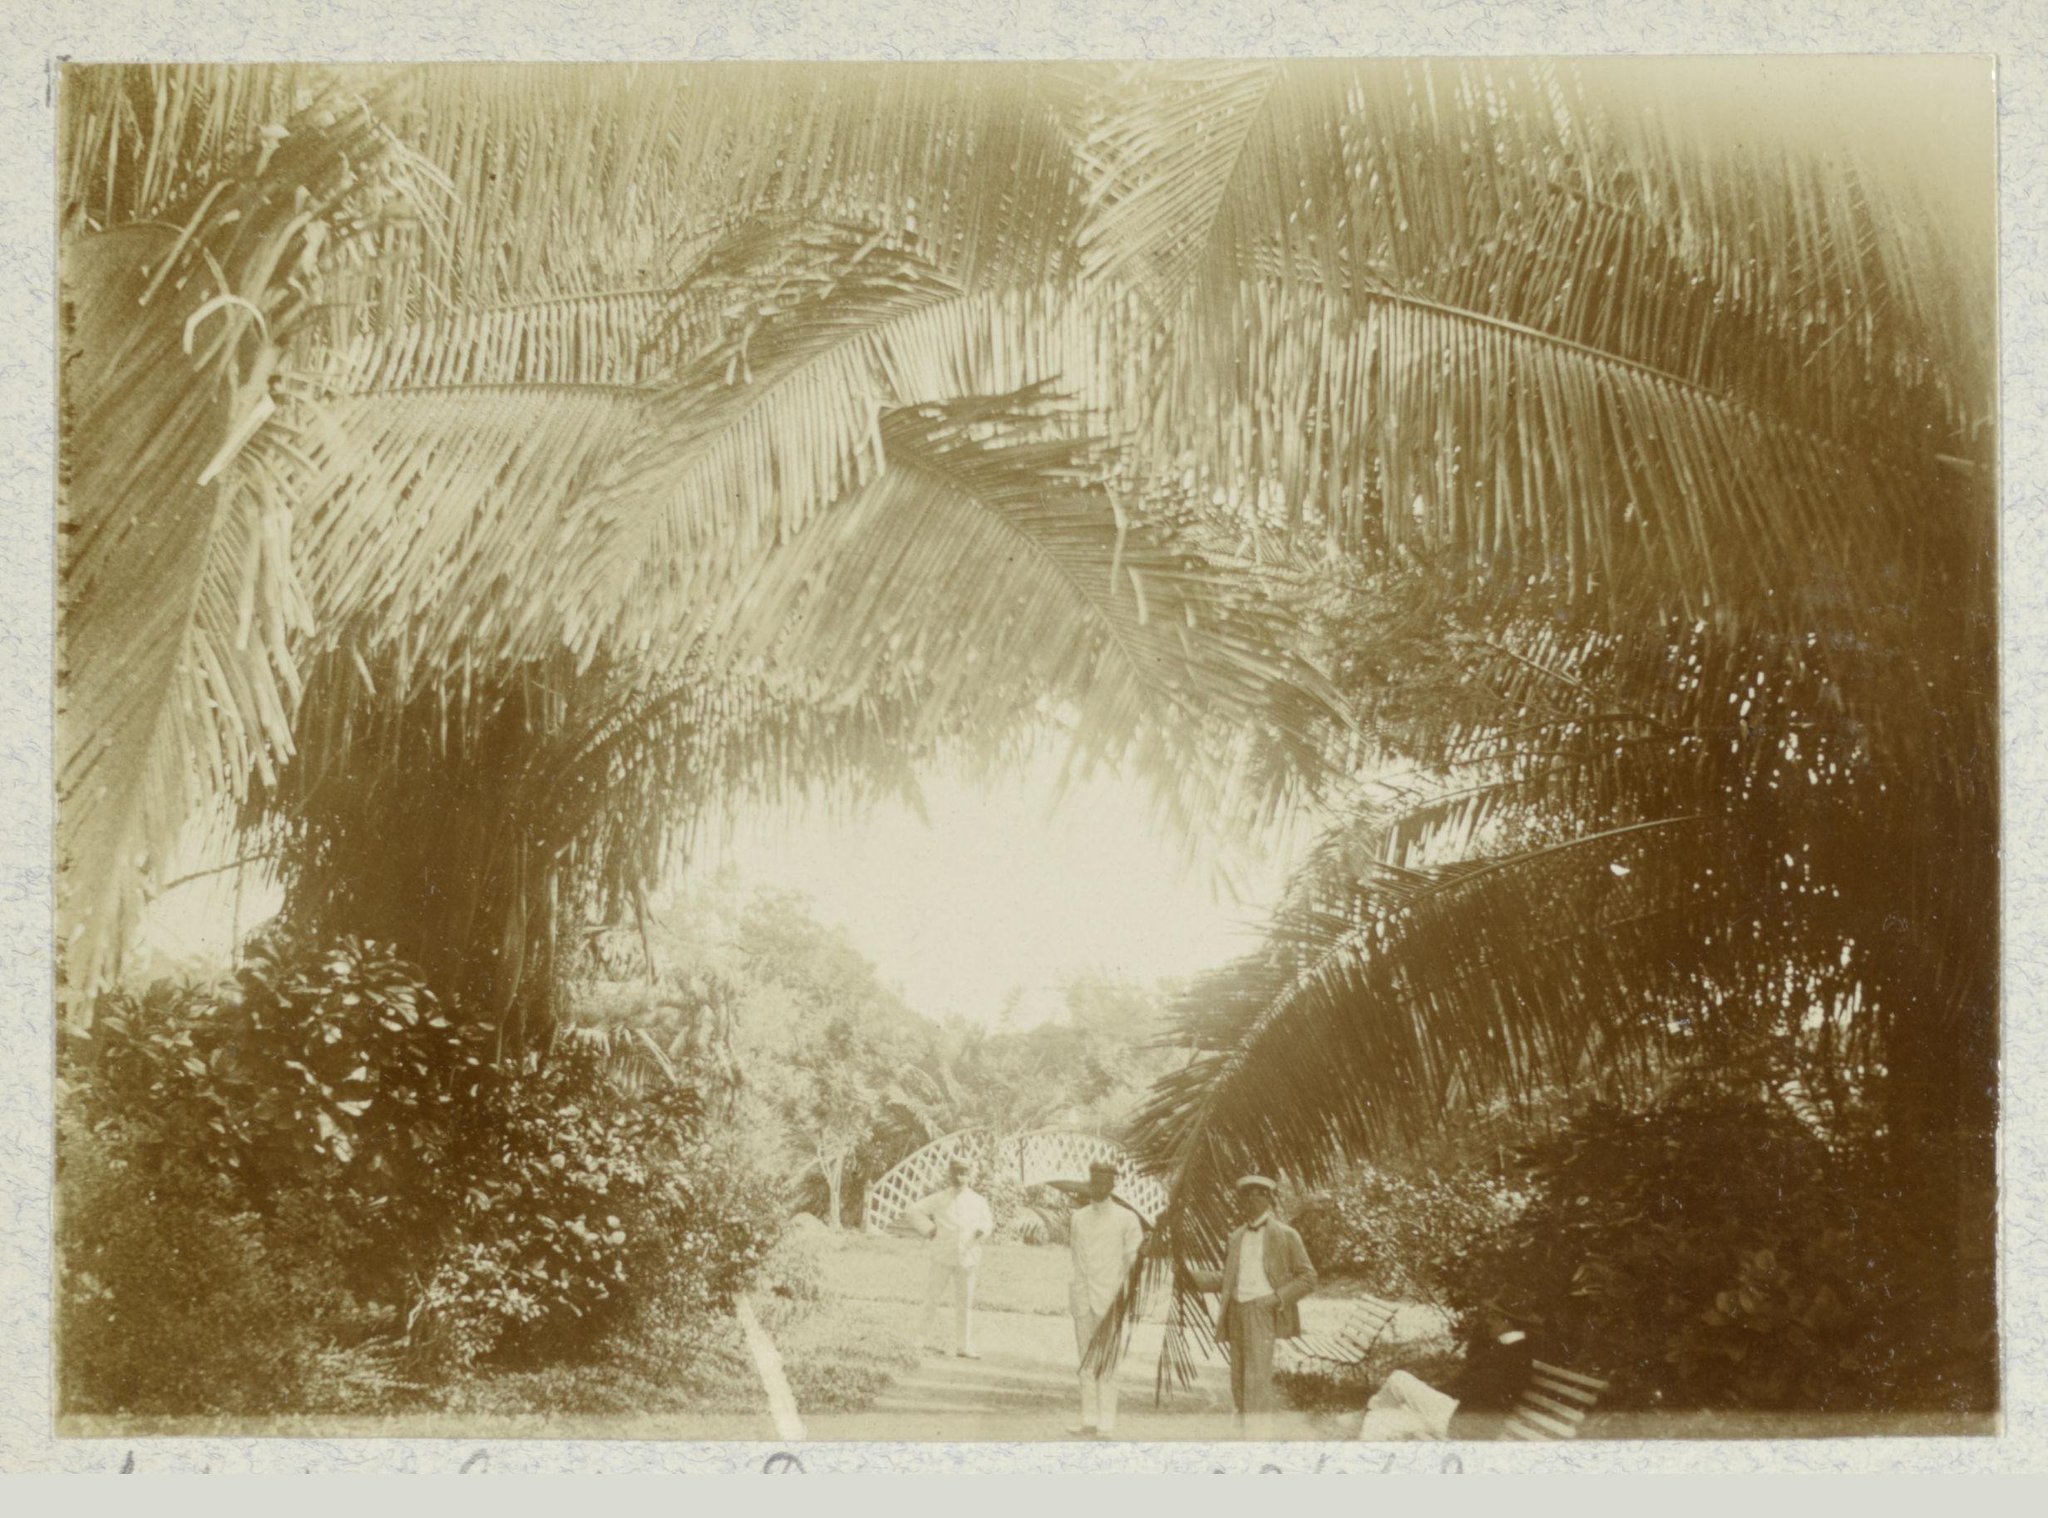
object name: photograph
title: Botanische Tuinen in Demerary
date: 1908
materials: photographic support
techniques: photography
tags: andries augustus boom, botanic garden, 'hortus botanicus'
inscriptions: inscription: ‘Botanical Garden. Demerara 28/03/08. van links naar rechts: Kapt Nie.... Boom. Gehrenbeek. Blanco’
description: Vier heren in de Botanische Tuinen in Demerary (Demerara), 28 maart 1908. Onderdeel van het fotoalbum van de familie Boom-Gonggrijp in Suriname en Curaçao.